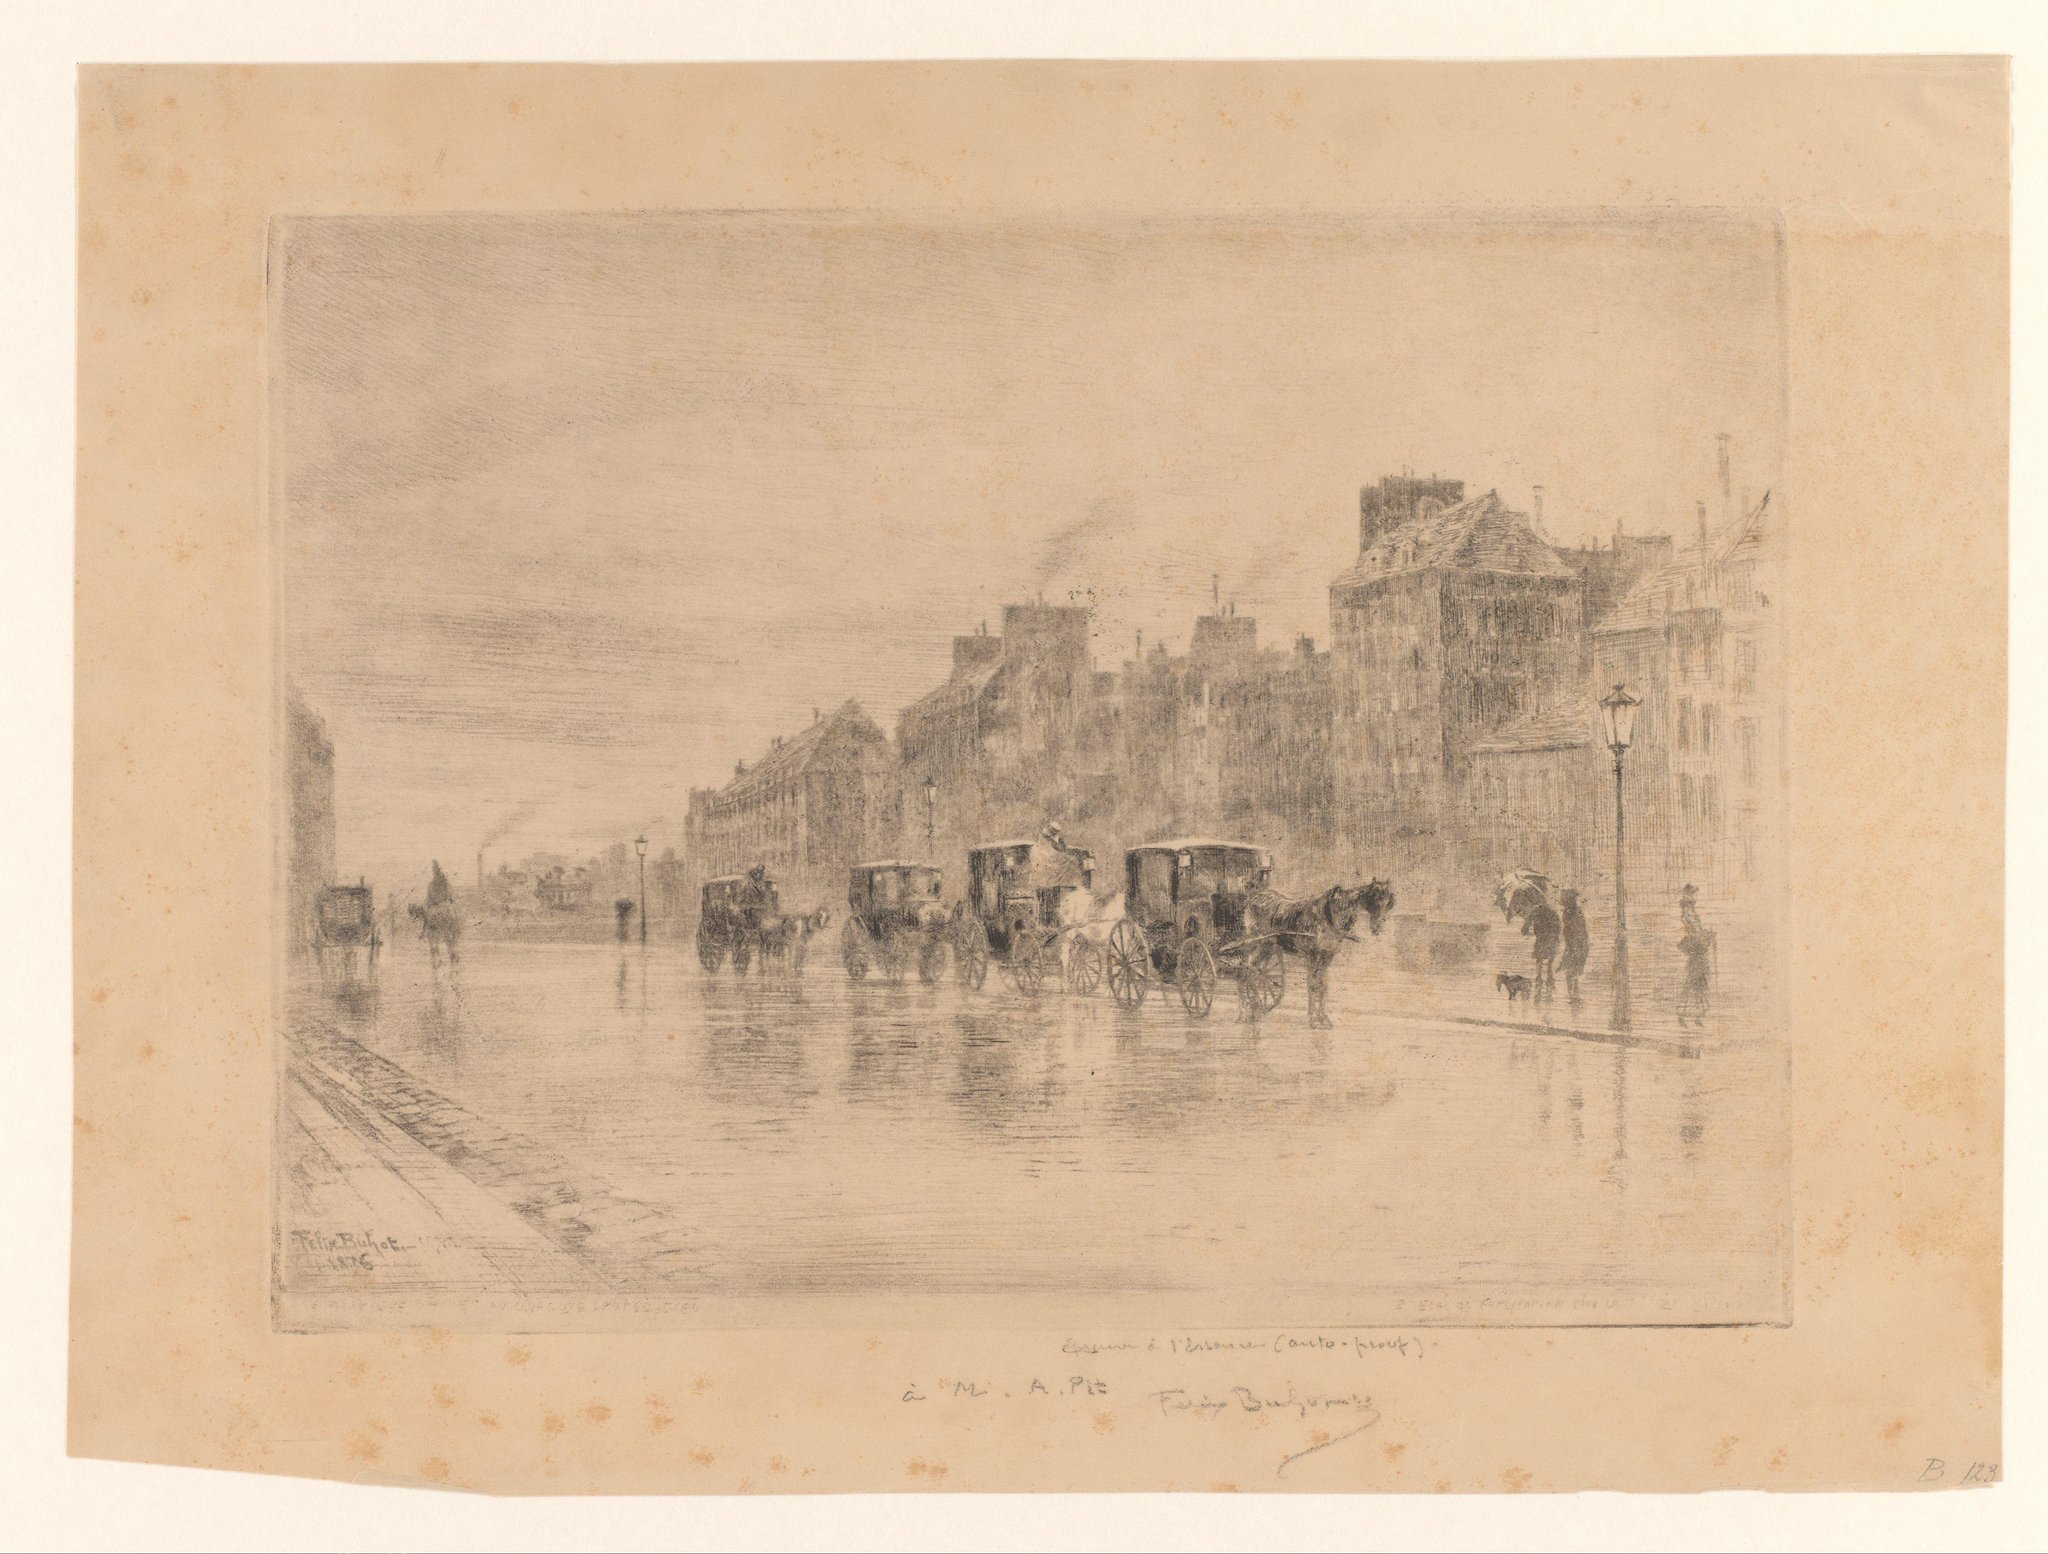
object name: print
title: Gezicht op een straat met koetsen op een regenachtige dag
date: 1876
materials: paper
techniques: aquatint, drypoint, etching, roulette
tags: four-wheeled, animal-drawn vehicle, e.g.: cab, carriage, coach, rain, street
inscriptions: signature: ‘à A. Pit Felix Buhot’, inscription: ‘Epreuve à l'Essa[...] (auto-proof).’, collector's mark: Lugt 2233